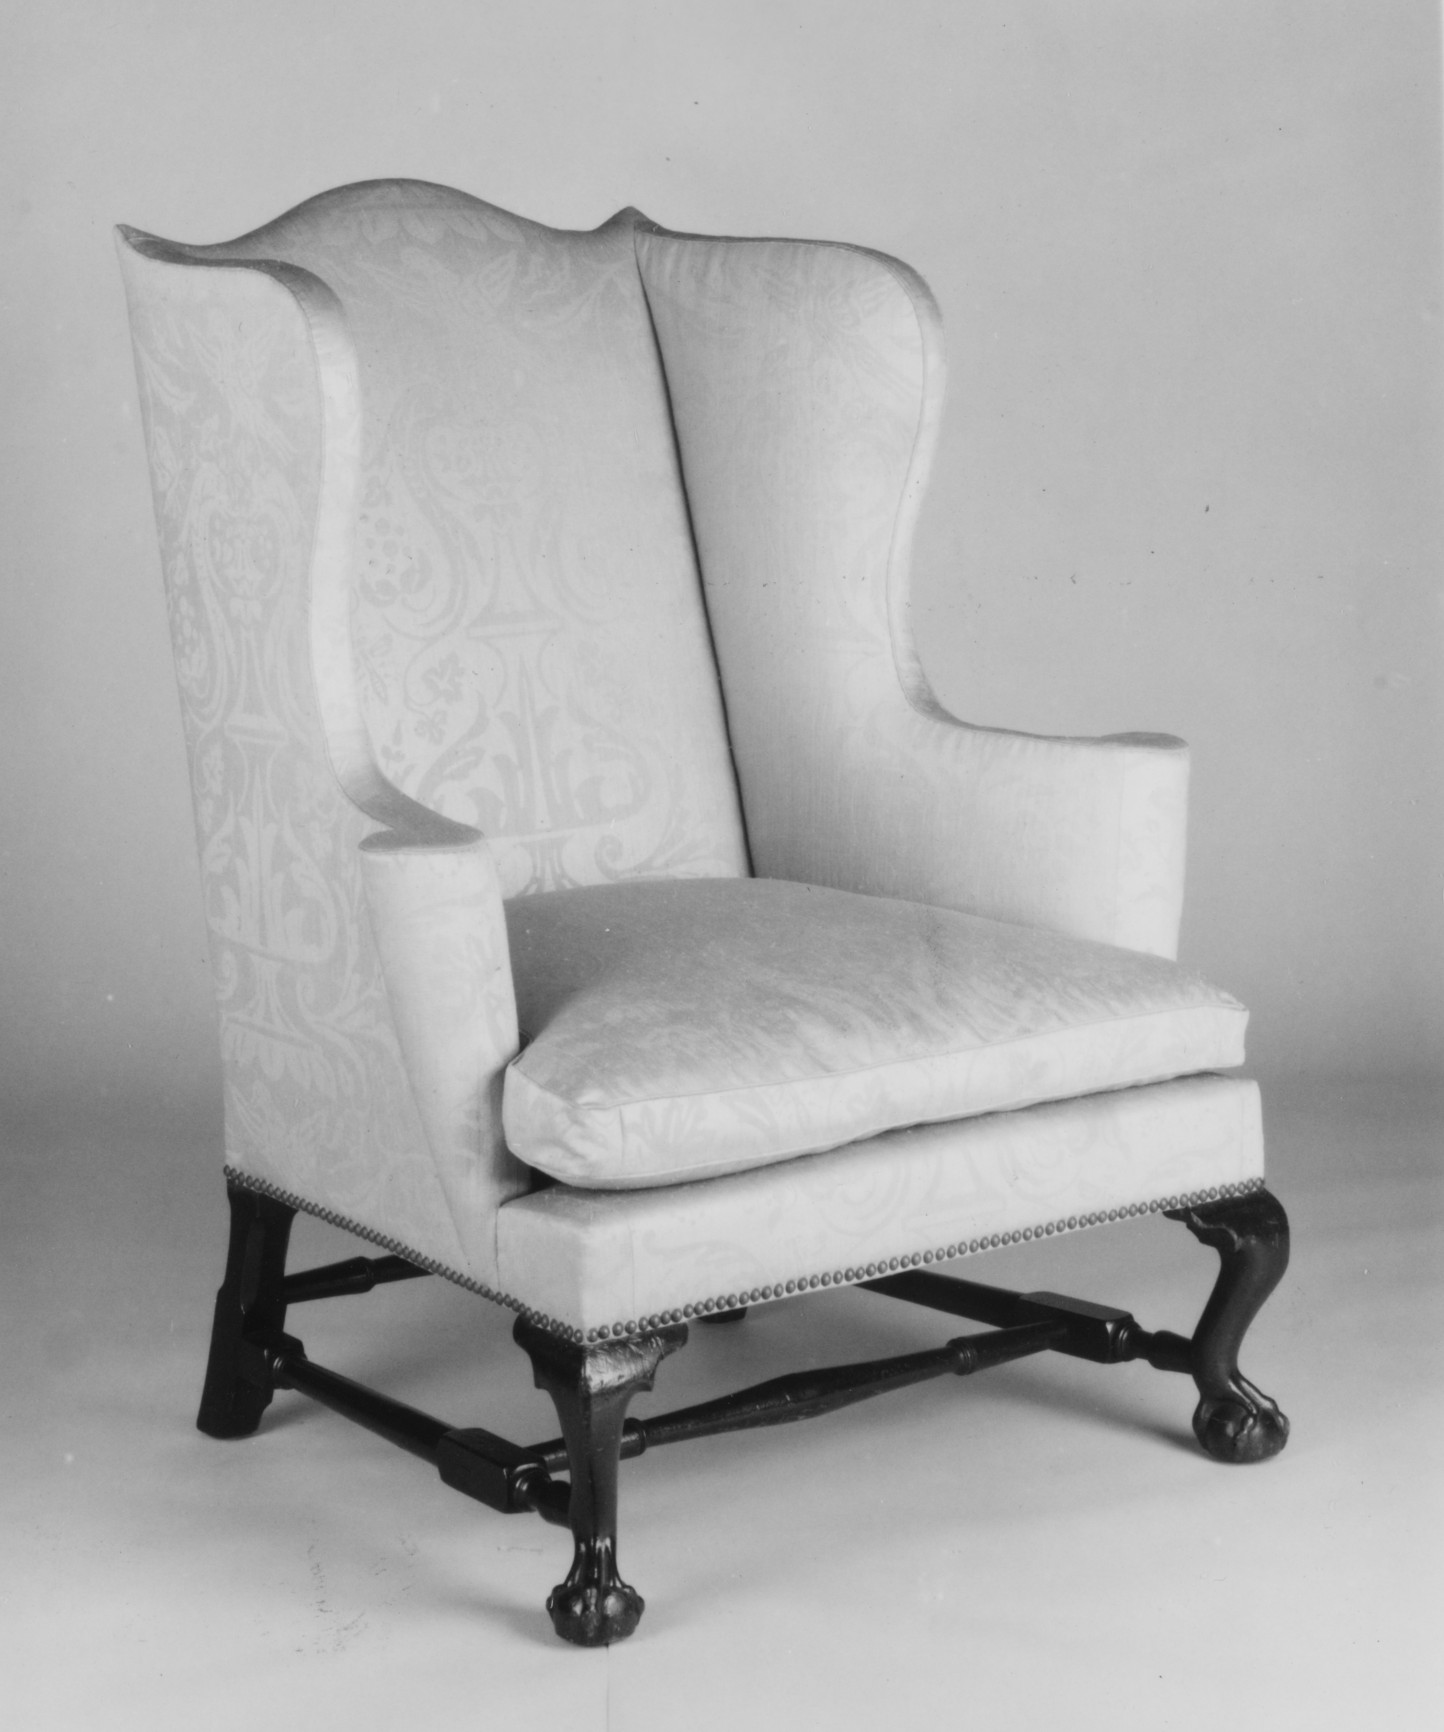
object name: easy chair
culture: american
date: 1760-1790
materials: wood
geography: united states